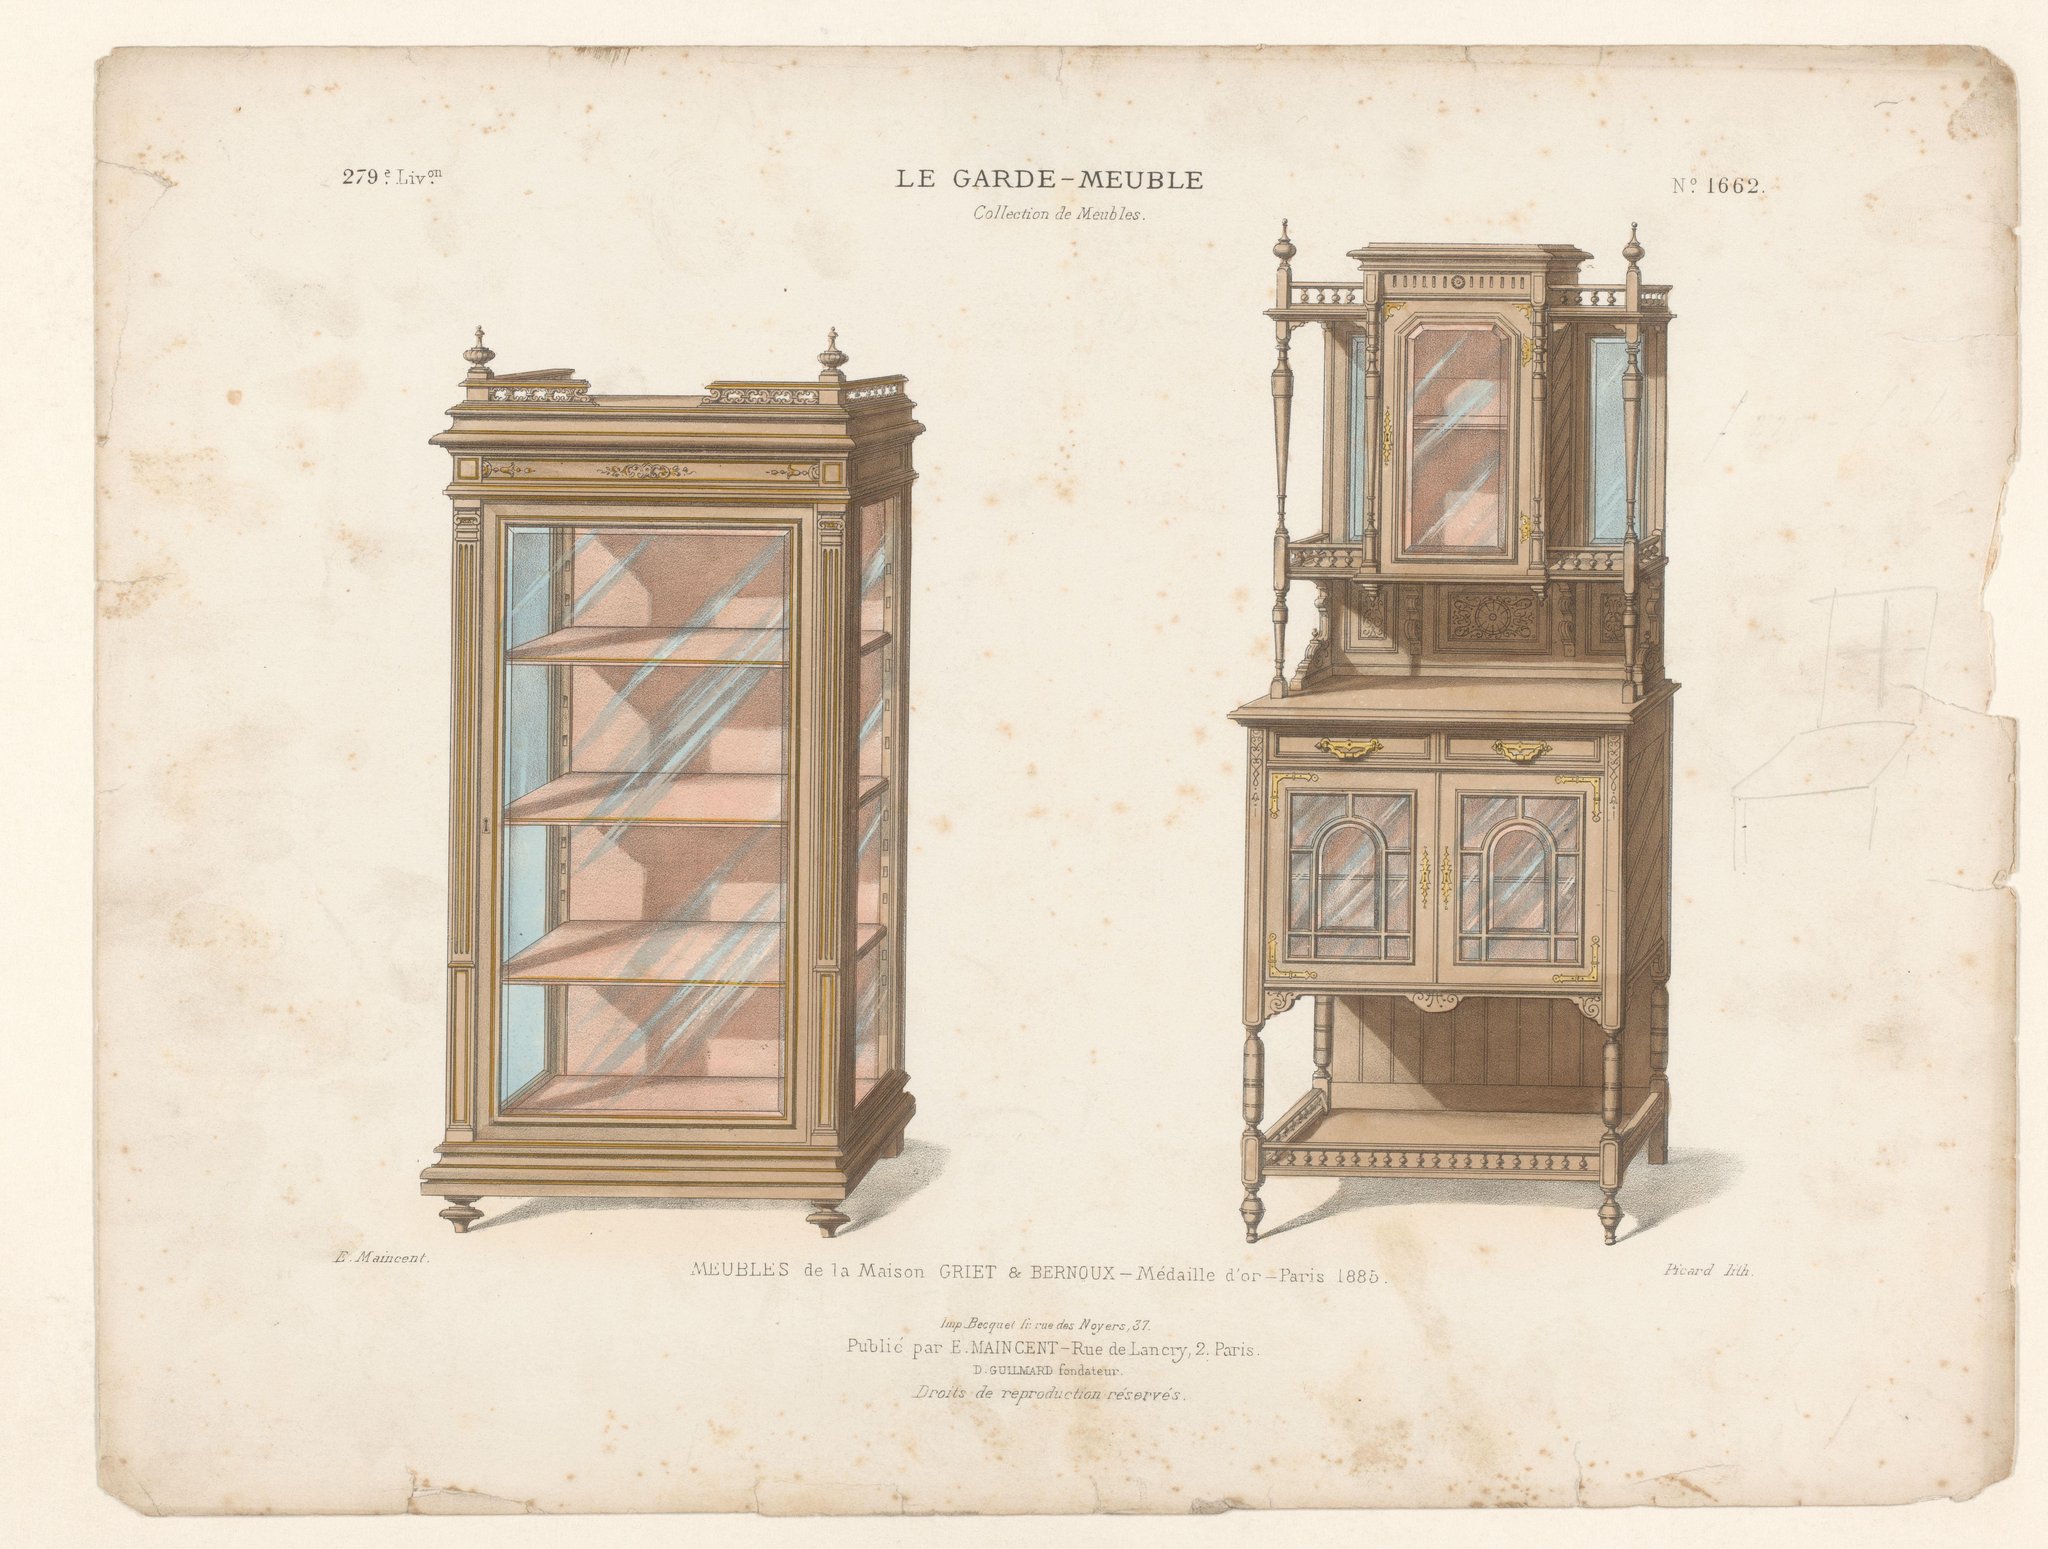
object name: print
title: Le garde-meuble / Collection de Meubles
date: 1885-1895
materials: paper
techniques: hand coloring, lithograph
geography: paris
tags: furniture for storage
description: Ieder Livraison in de serie Le Garde-Meuble bevat negen platen: drie 'sièges' (zitmeubels), drie 'meubles' (diverse meubels zoals tafels en kasten) en drie 'tentures' (gordijnen en draperieën).